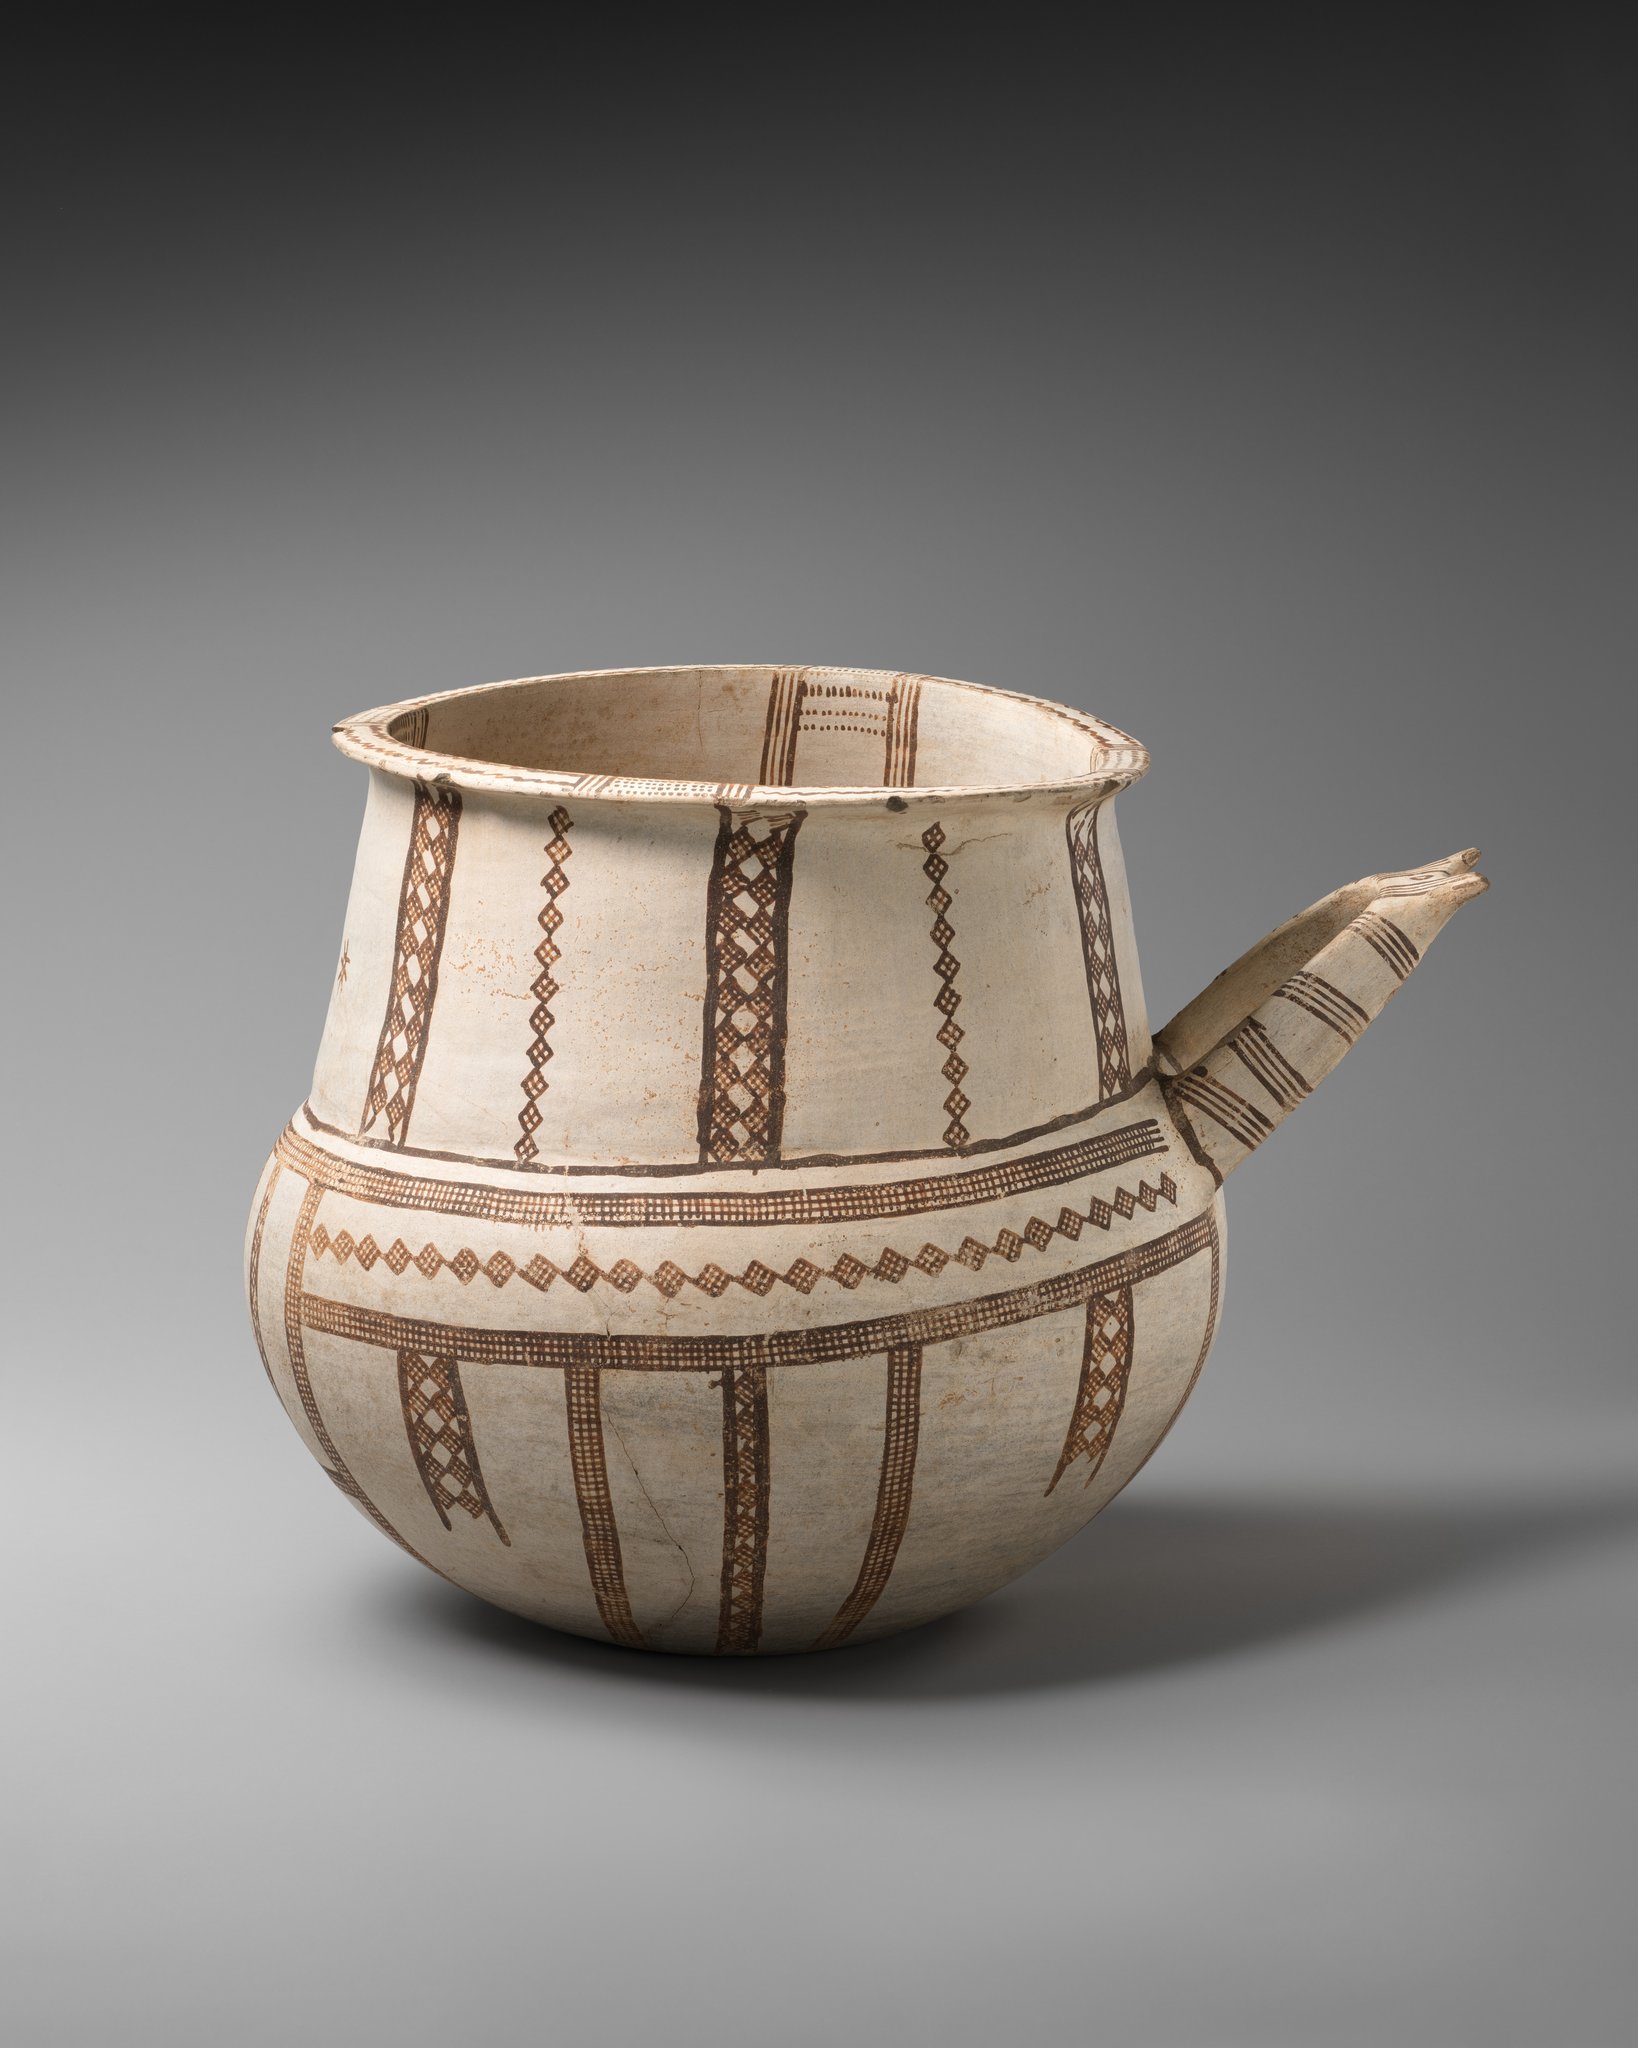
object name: krater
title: Terracotta krater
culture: cypriot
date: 1450-1200 BCE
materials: terracotta